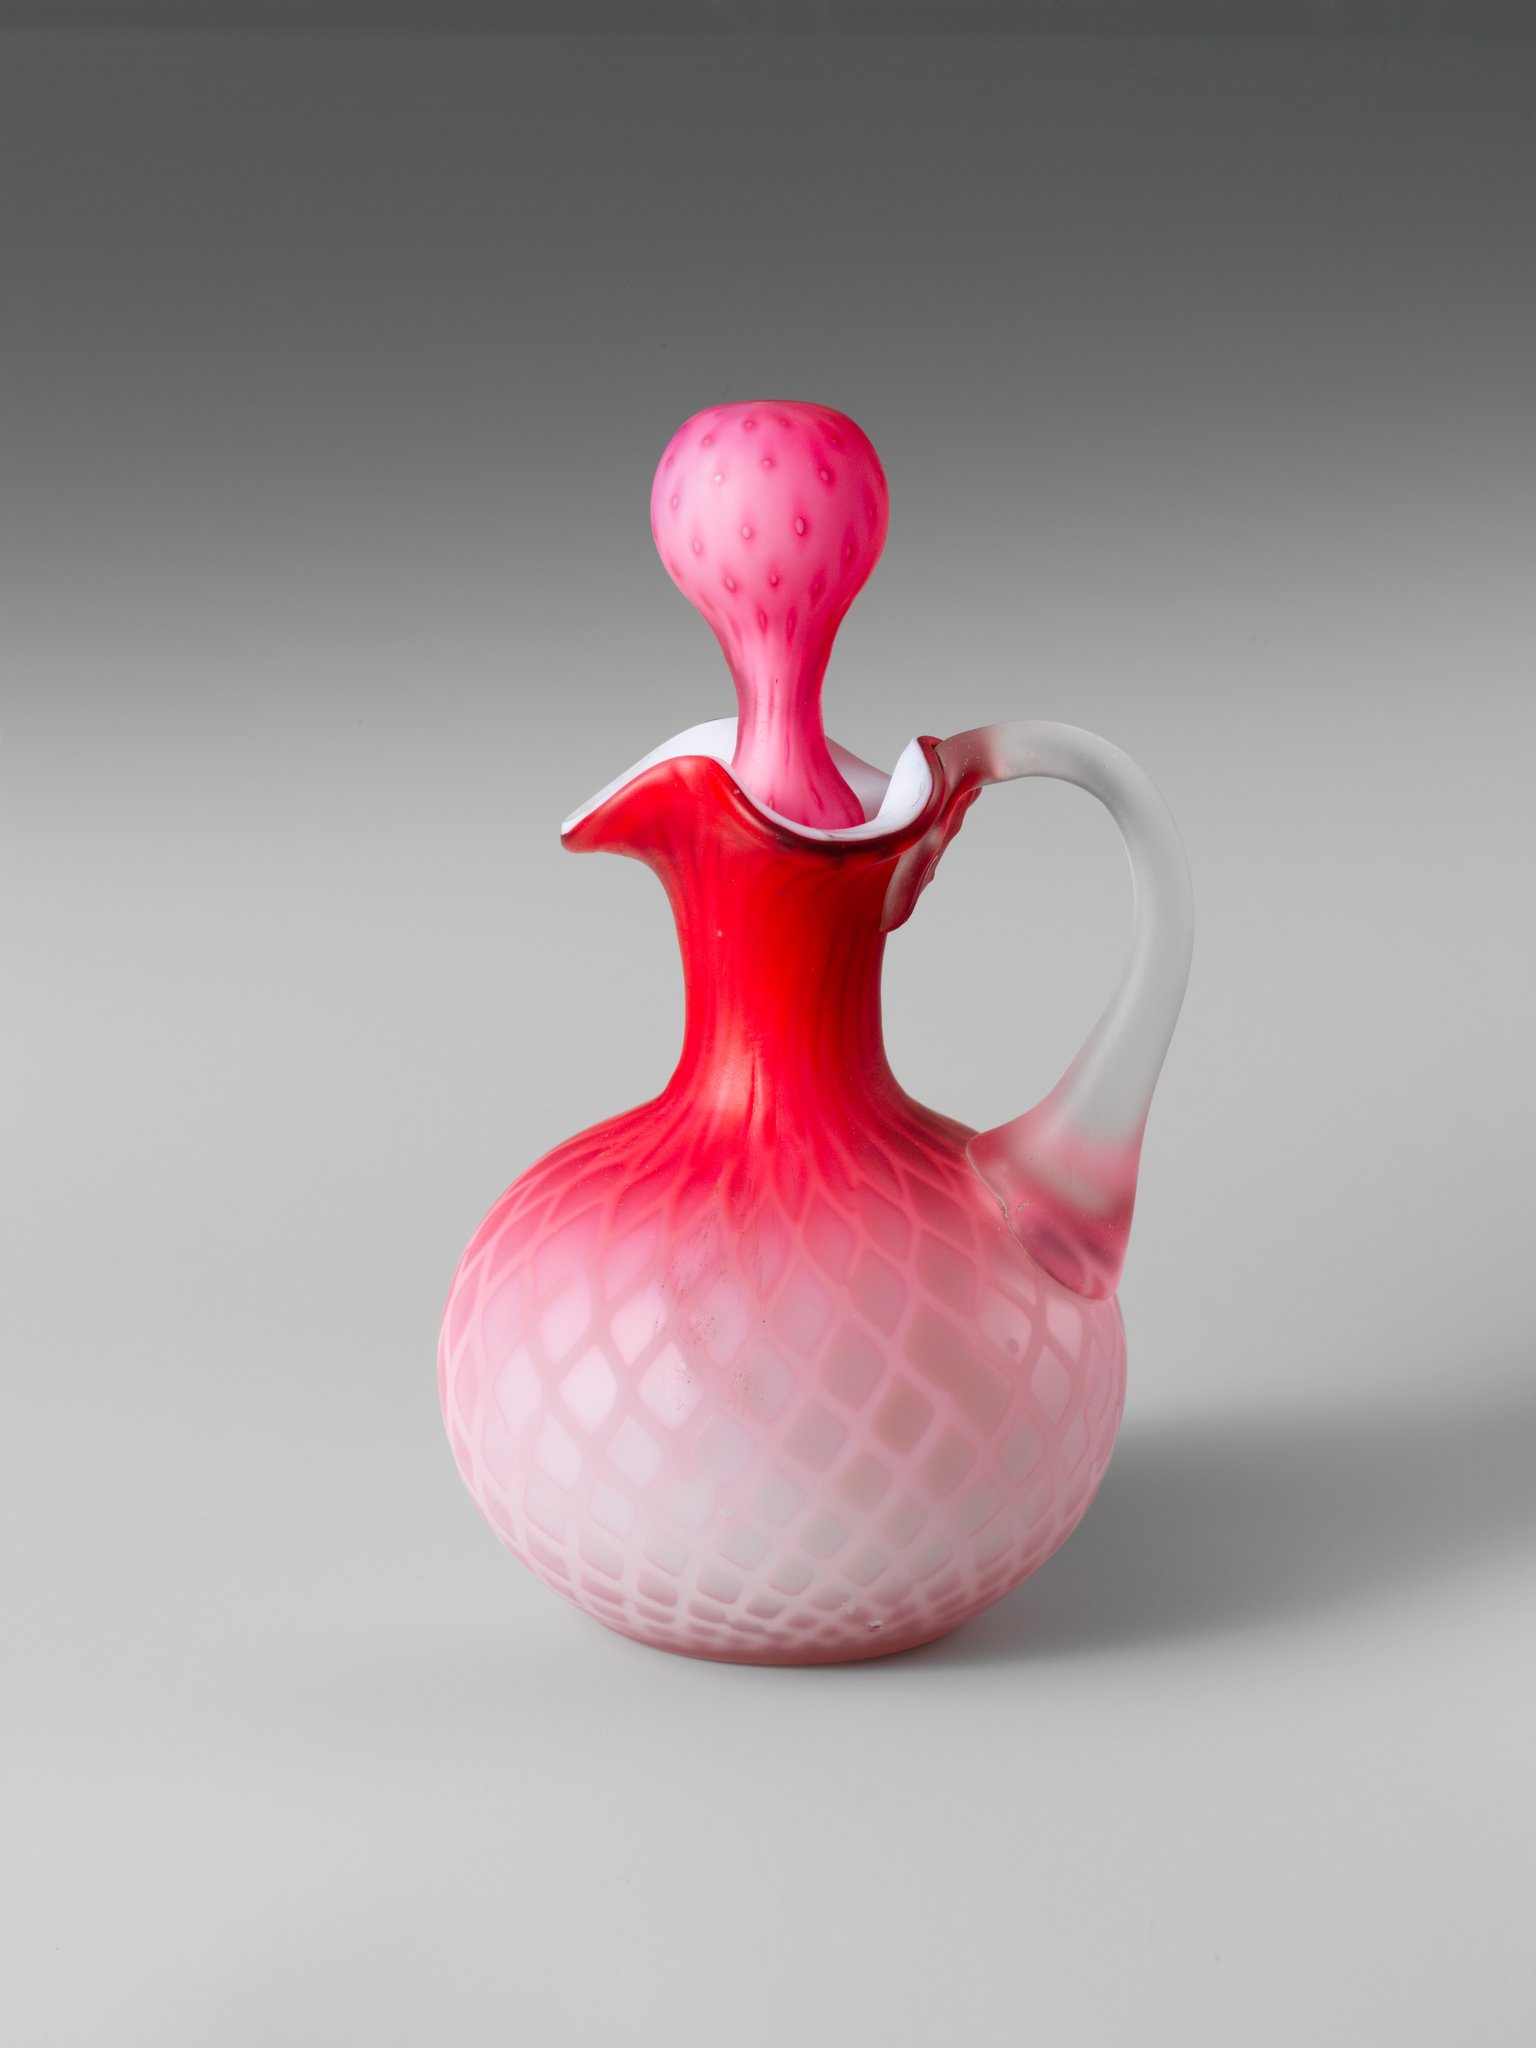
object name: cruet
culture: american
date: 1885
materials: glass, textile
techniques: glassblowing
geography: united states